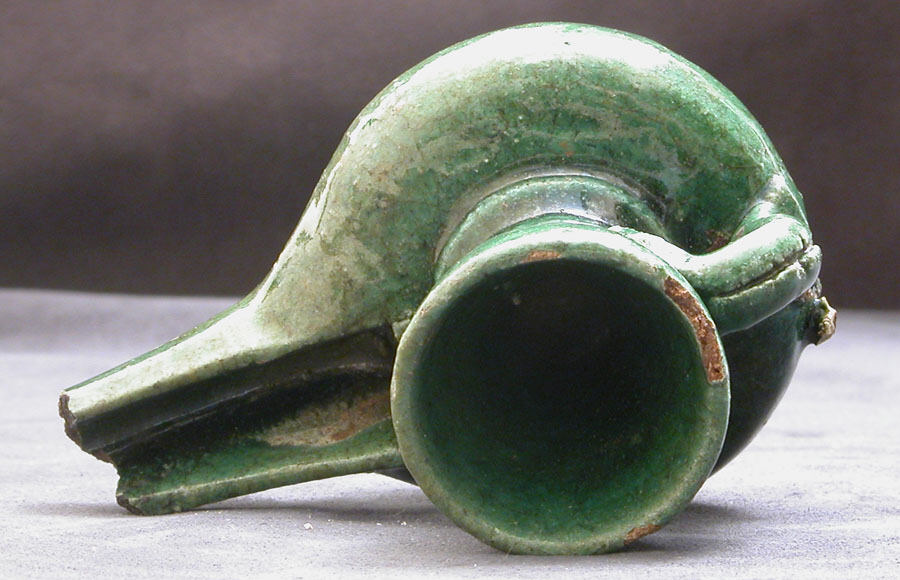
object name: lamp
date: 1201-1400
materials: earthenware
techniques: glazing, molding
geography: egypt